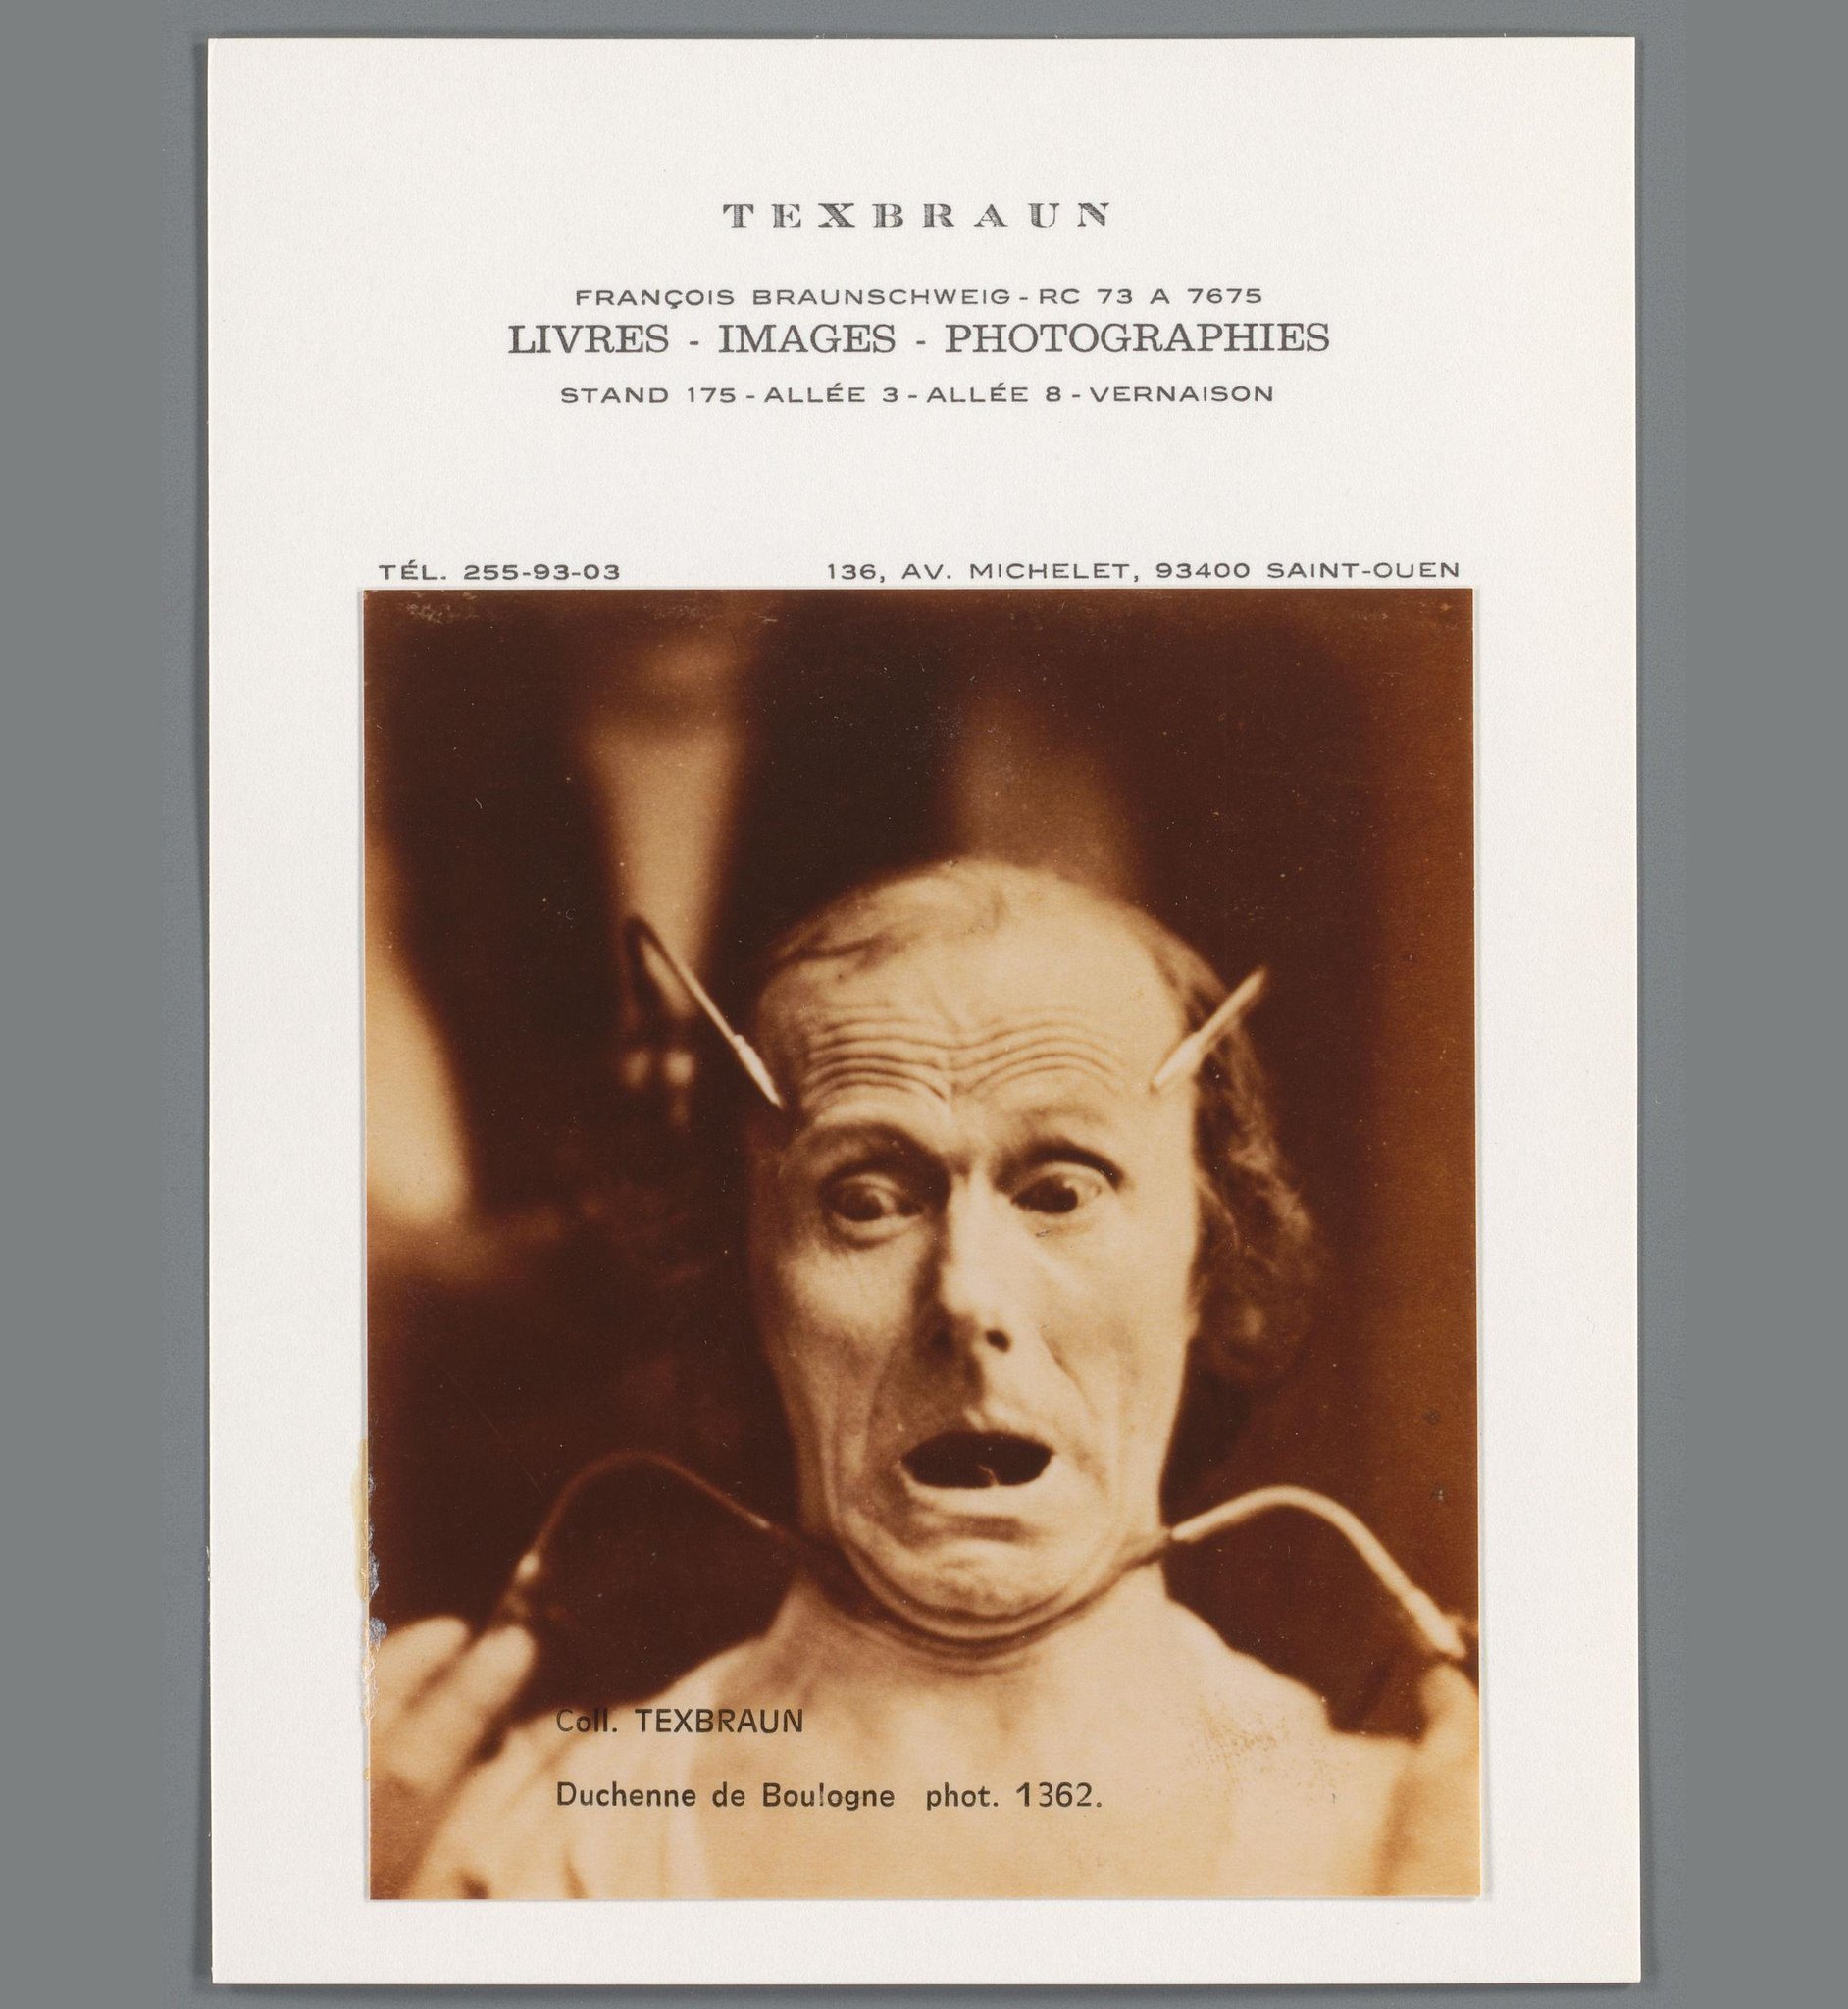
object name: new year card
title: Nieuwjaarswens voor 1978 met een fotoreproductie van een foto van een proefpersoon van Duchenne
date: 1977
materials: paper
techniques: chromogenic print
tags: l.j. hartkamp, morphology of facial expression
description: Nieuwjaarswens van Francois Braunschweig gericht aan Bert Hartkamp. In dezelfde envelop zit een (kopie van een) bedankbrief van Bert Hartkamp gericht aan Francois Braunschweig.